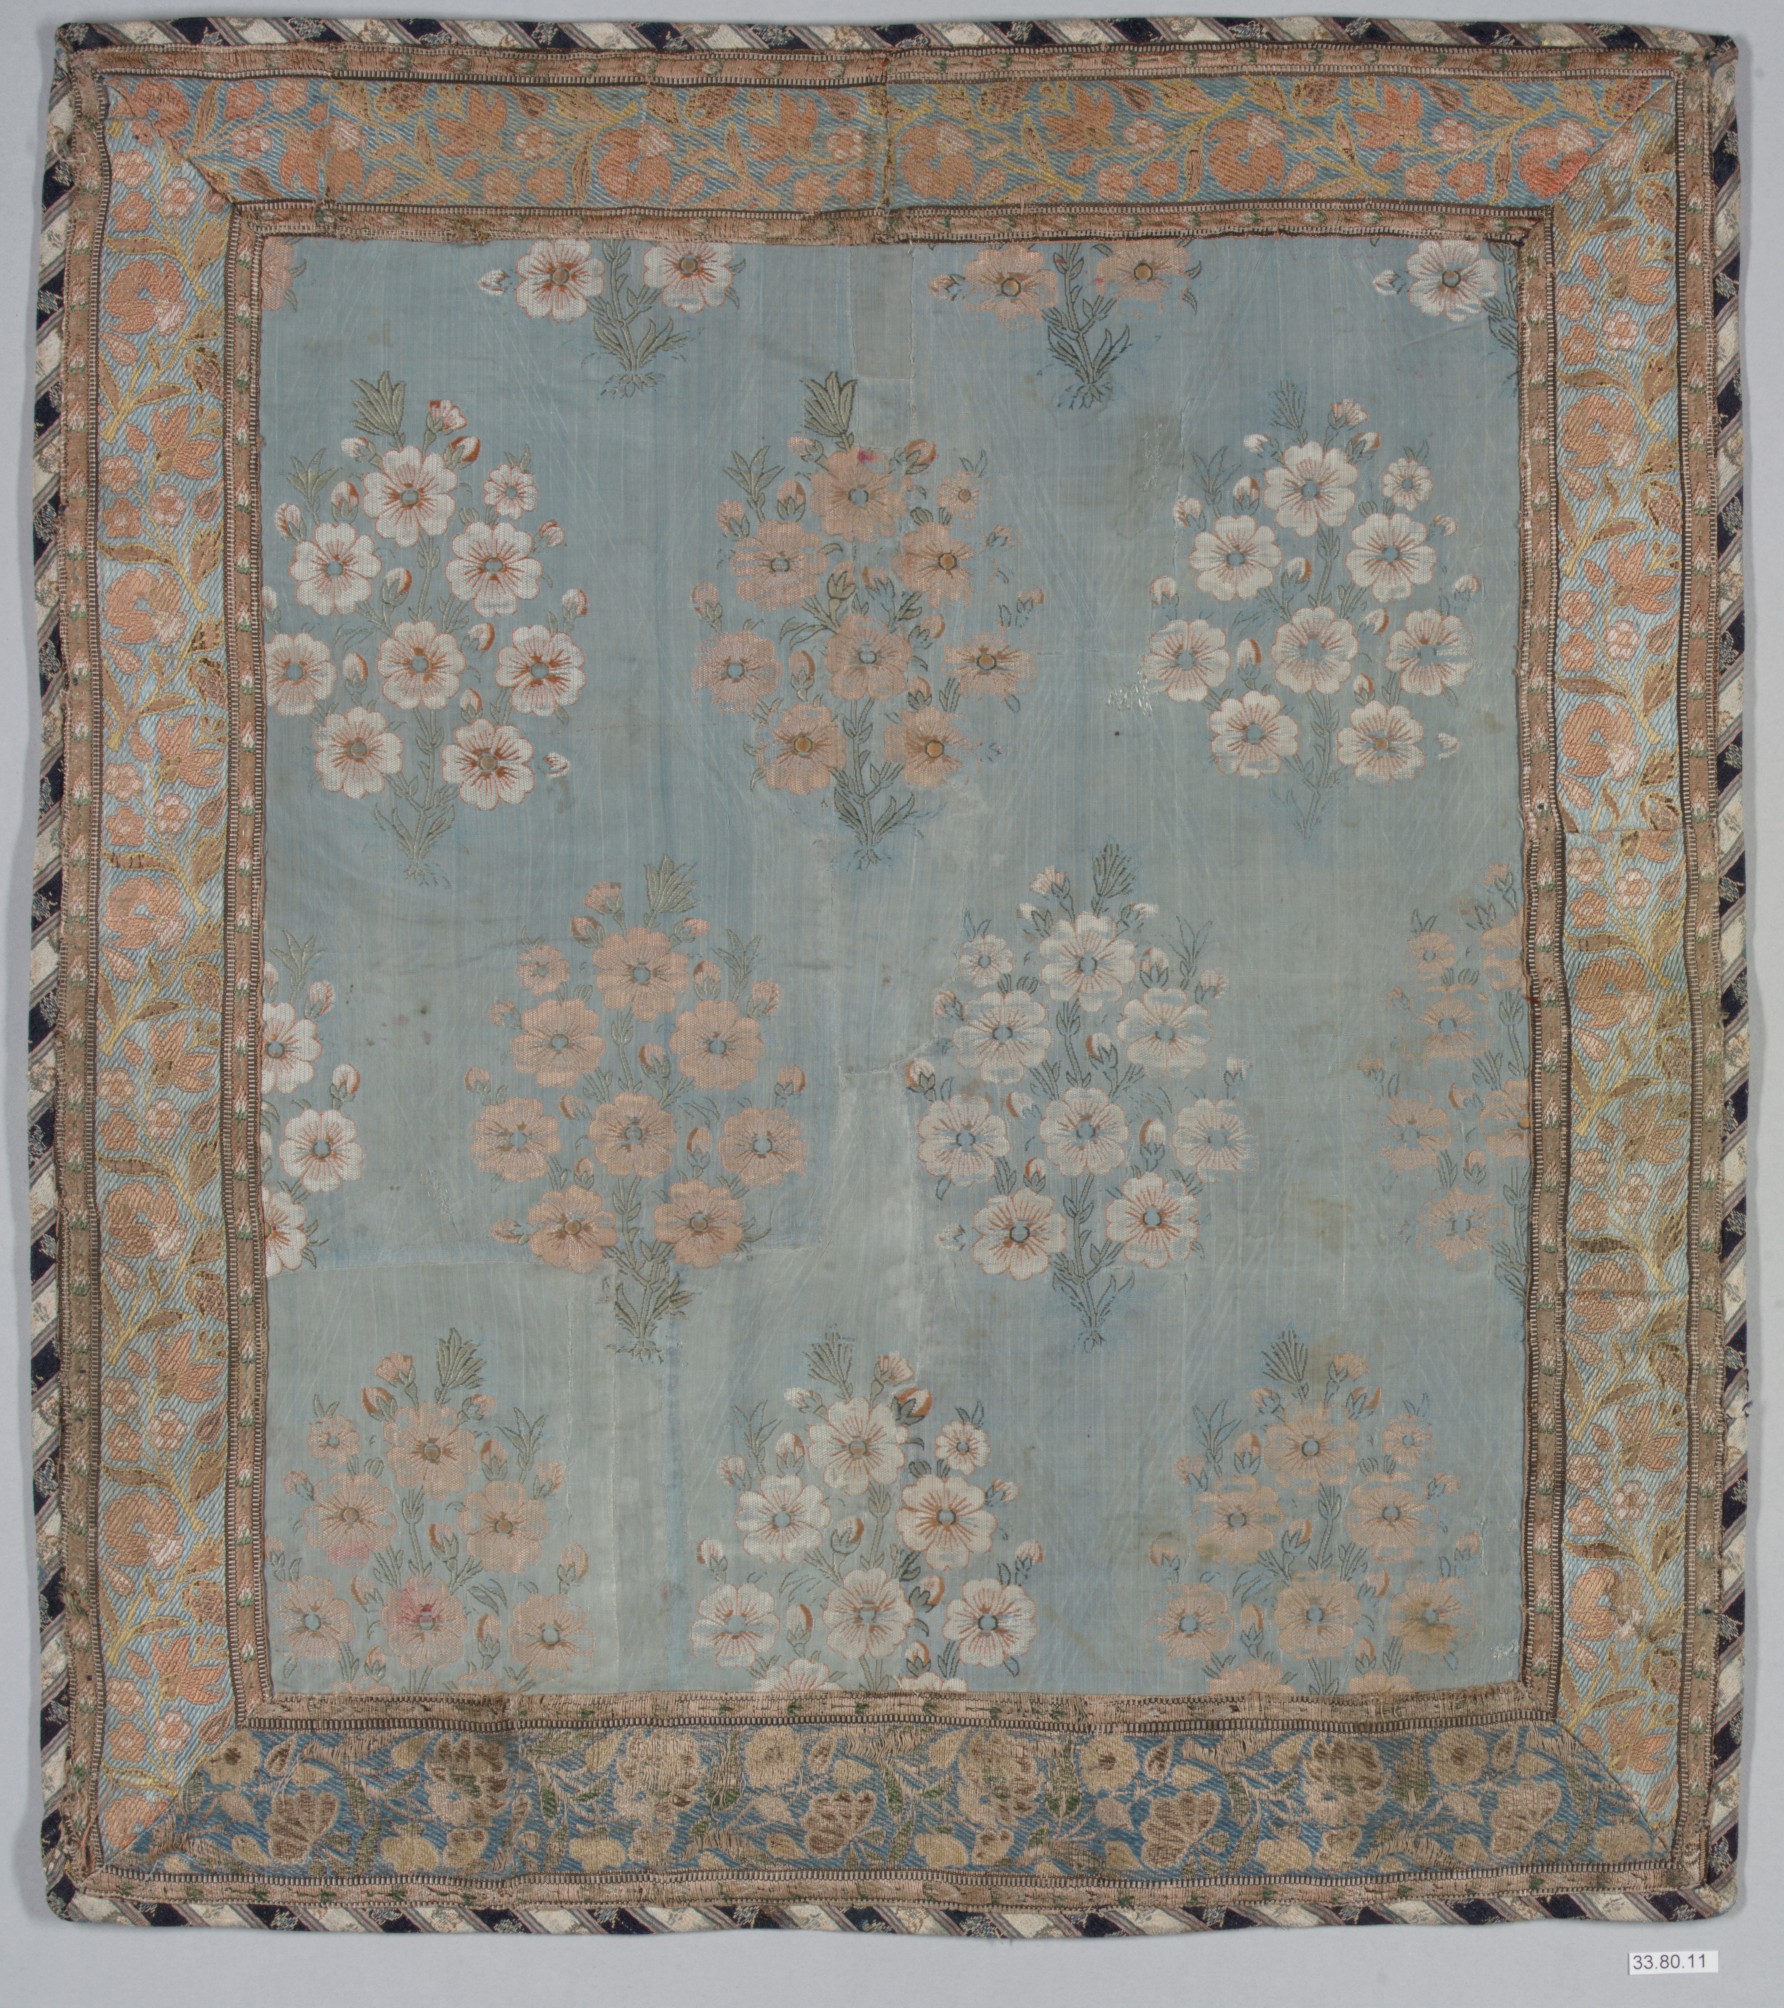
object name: cover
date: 1601-1700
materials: silk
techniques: weave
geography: iran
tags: flowers